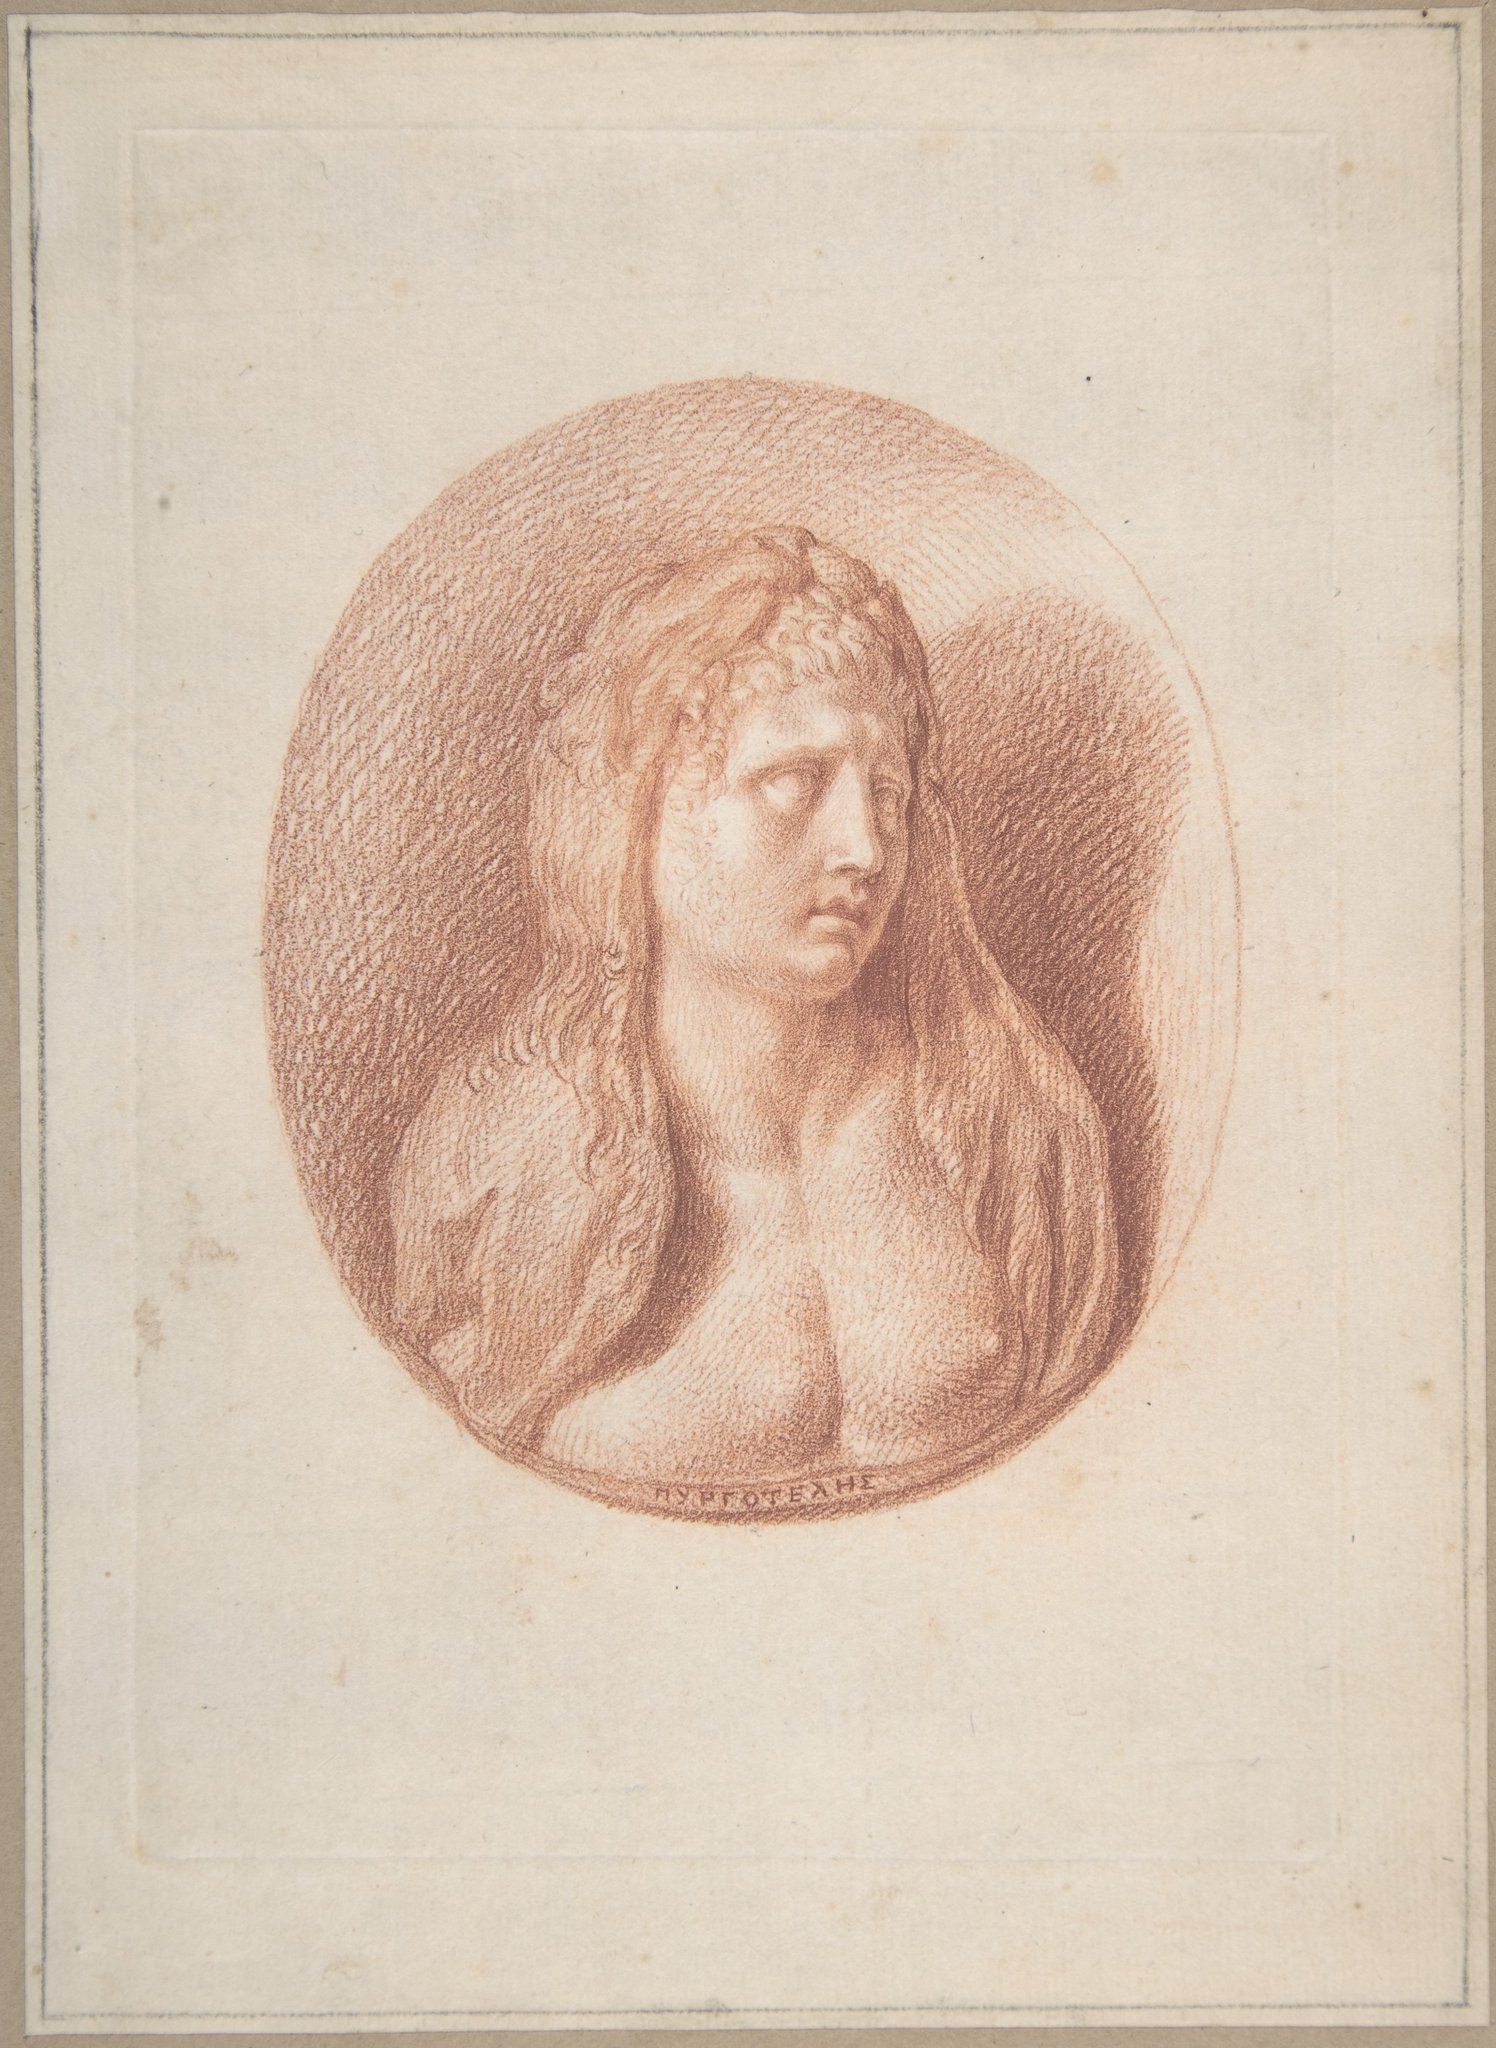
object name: drawing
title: Presumed Portrait of Alexander the Great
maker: bernard picart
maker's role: artist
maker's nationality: french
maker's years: 1673-1733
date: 1719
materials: chalk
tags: alexander the great,portraits